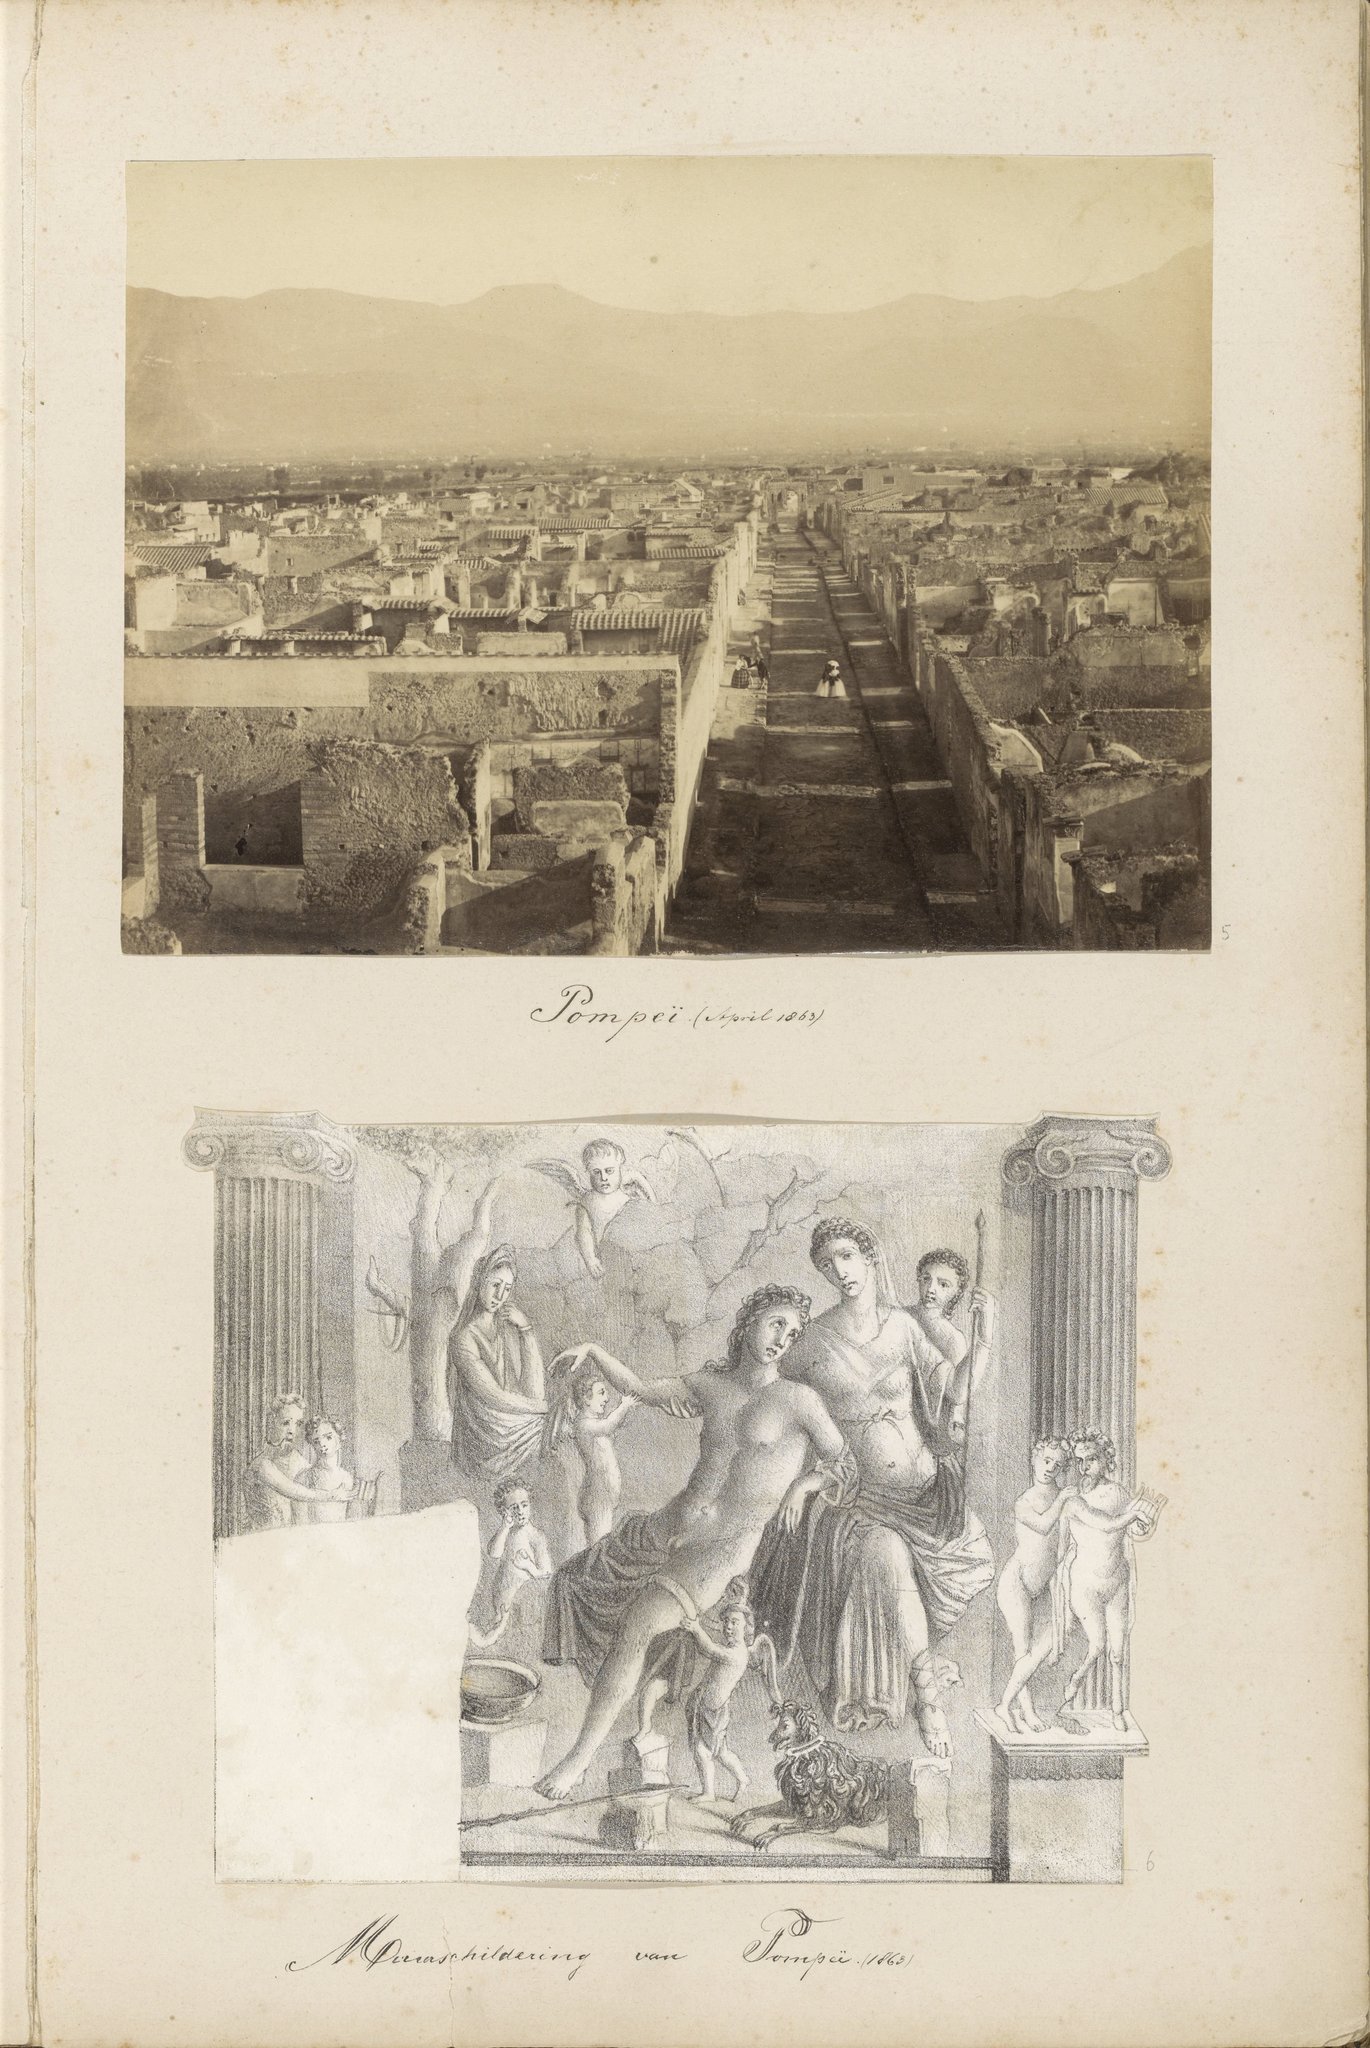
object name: album leaf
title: Mars en Venus, naar een muurschildering in Pompeï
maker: Anonymous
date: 1863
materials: paper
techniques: lithograph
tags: mars and venus as lovers, picture, painting, pompeii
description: Onderdeel van Fotoalbum van Robert Daniel Crommelin (1841-1907).